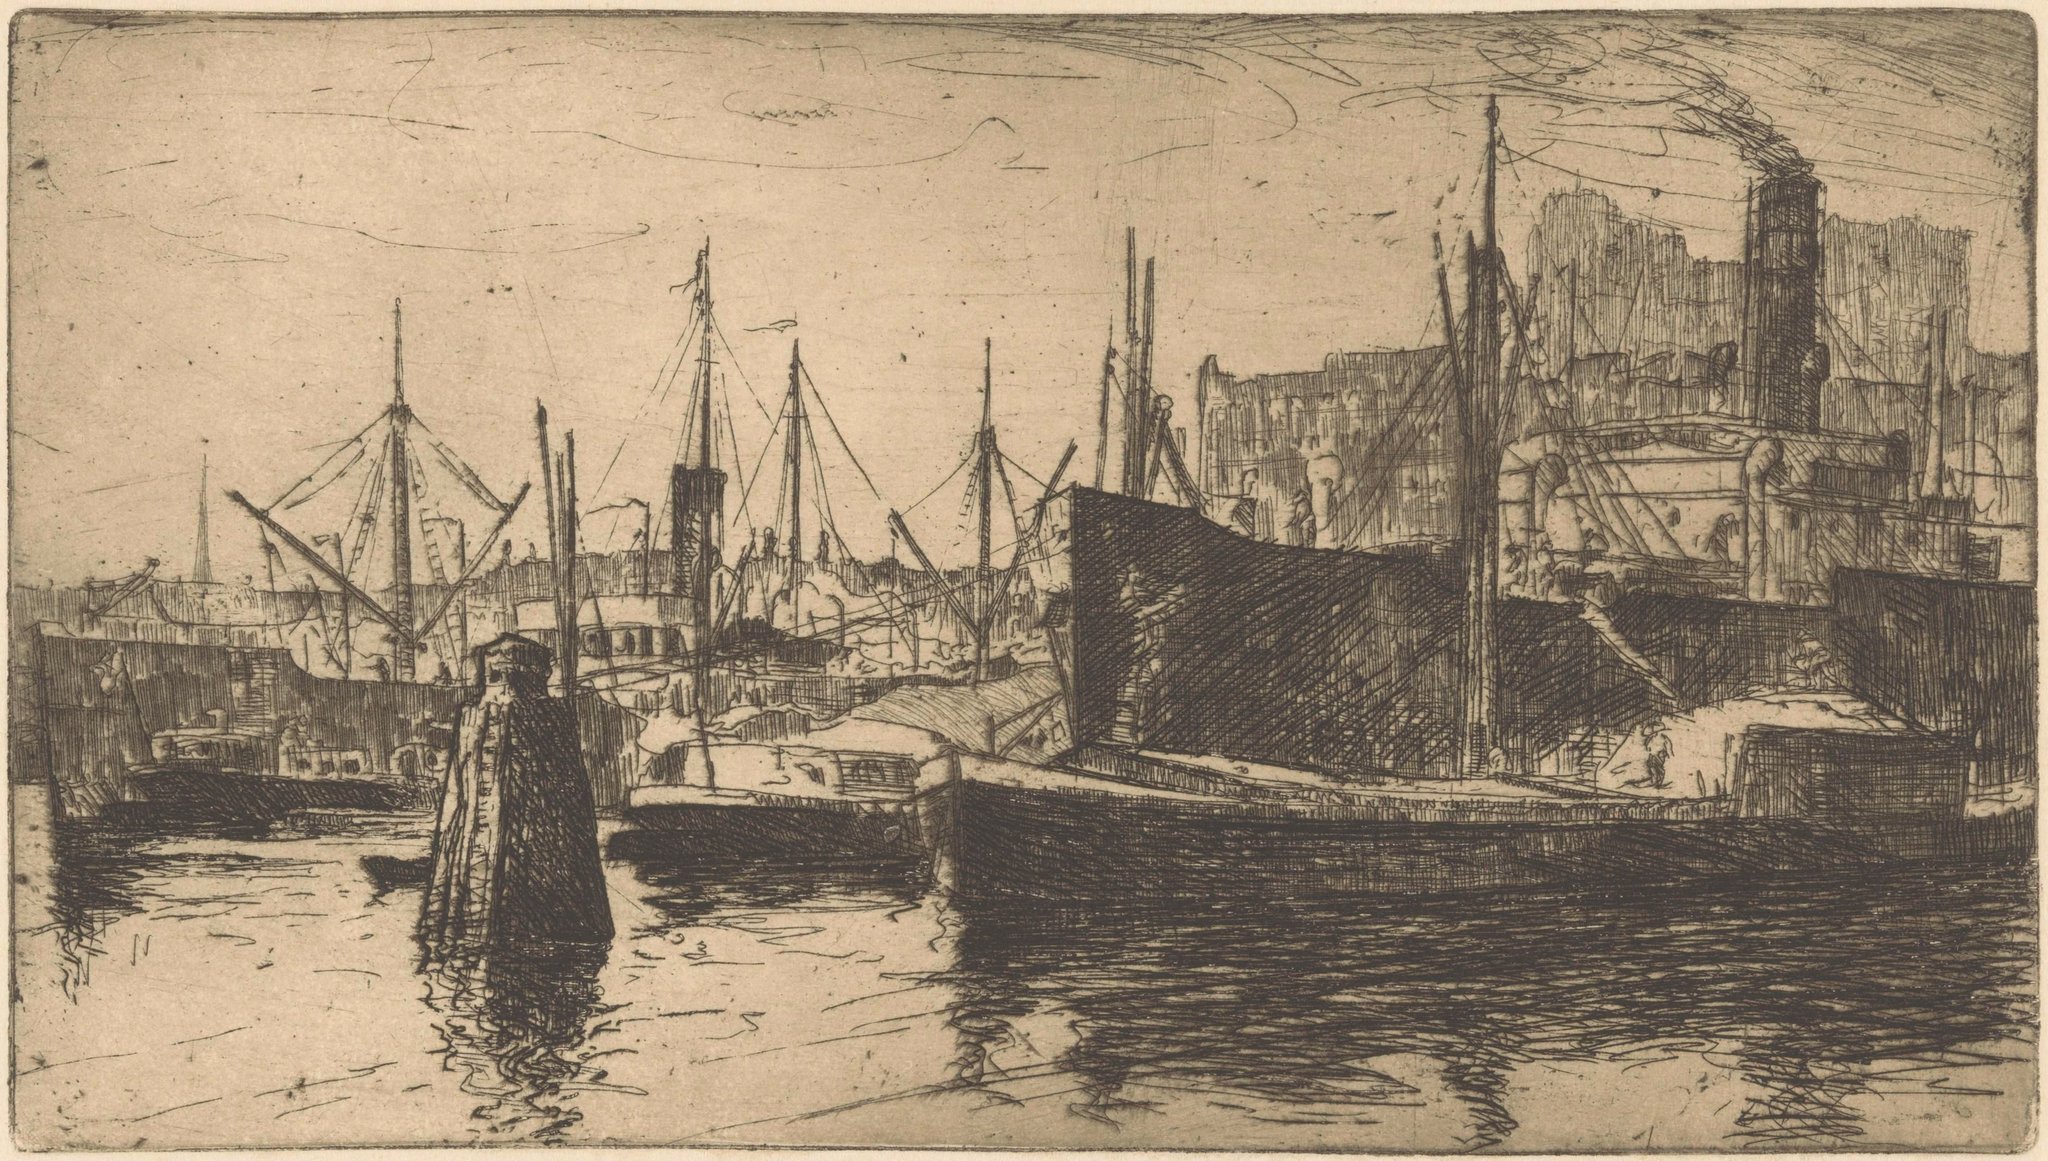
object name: print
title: Rotterdam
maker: willem adrianus grondhout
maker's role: draughtsman, painter, print maker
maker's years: 1878-1934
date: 1888-1934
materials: paper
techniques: etching, intaglio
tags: harbour, rotterdam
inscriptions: collector's mark: Lugt 2228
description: Afgemeerde schepen in de haven van Rotterdam. Op de achtergrond bebouwing.